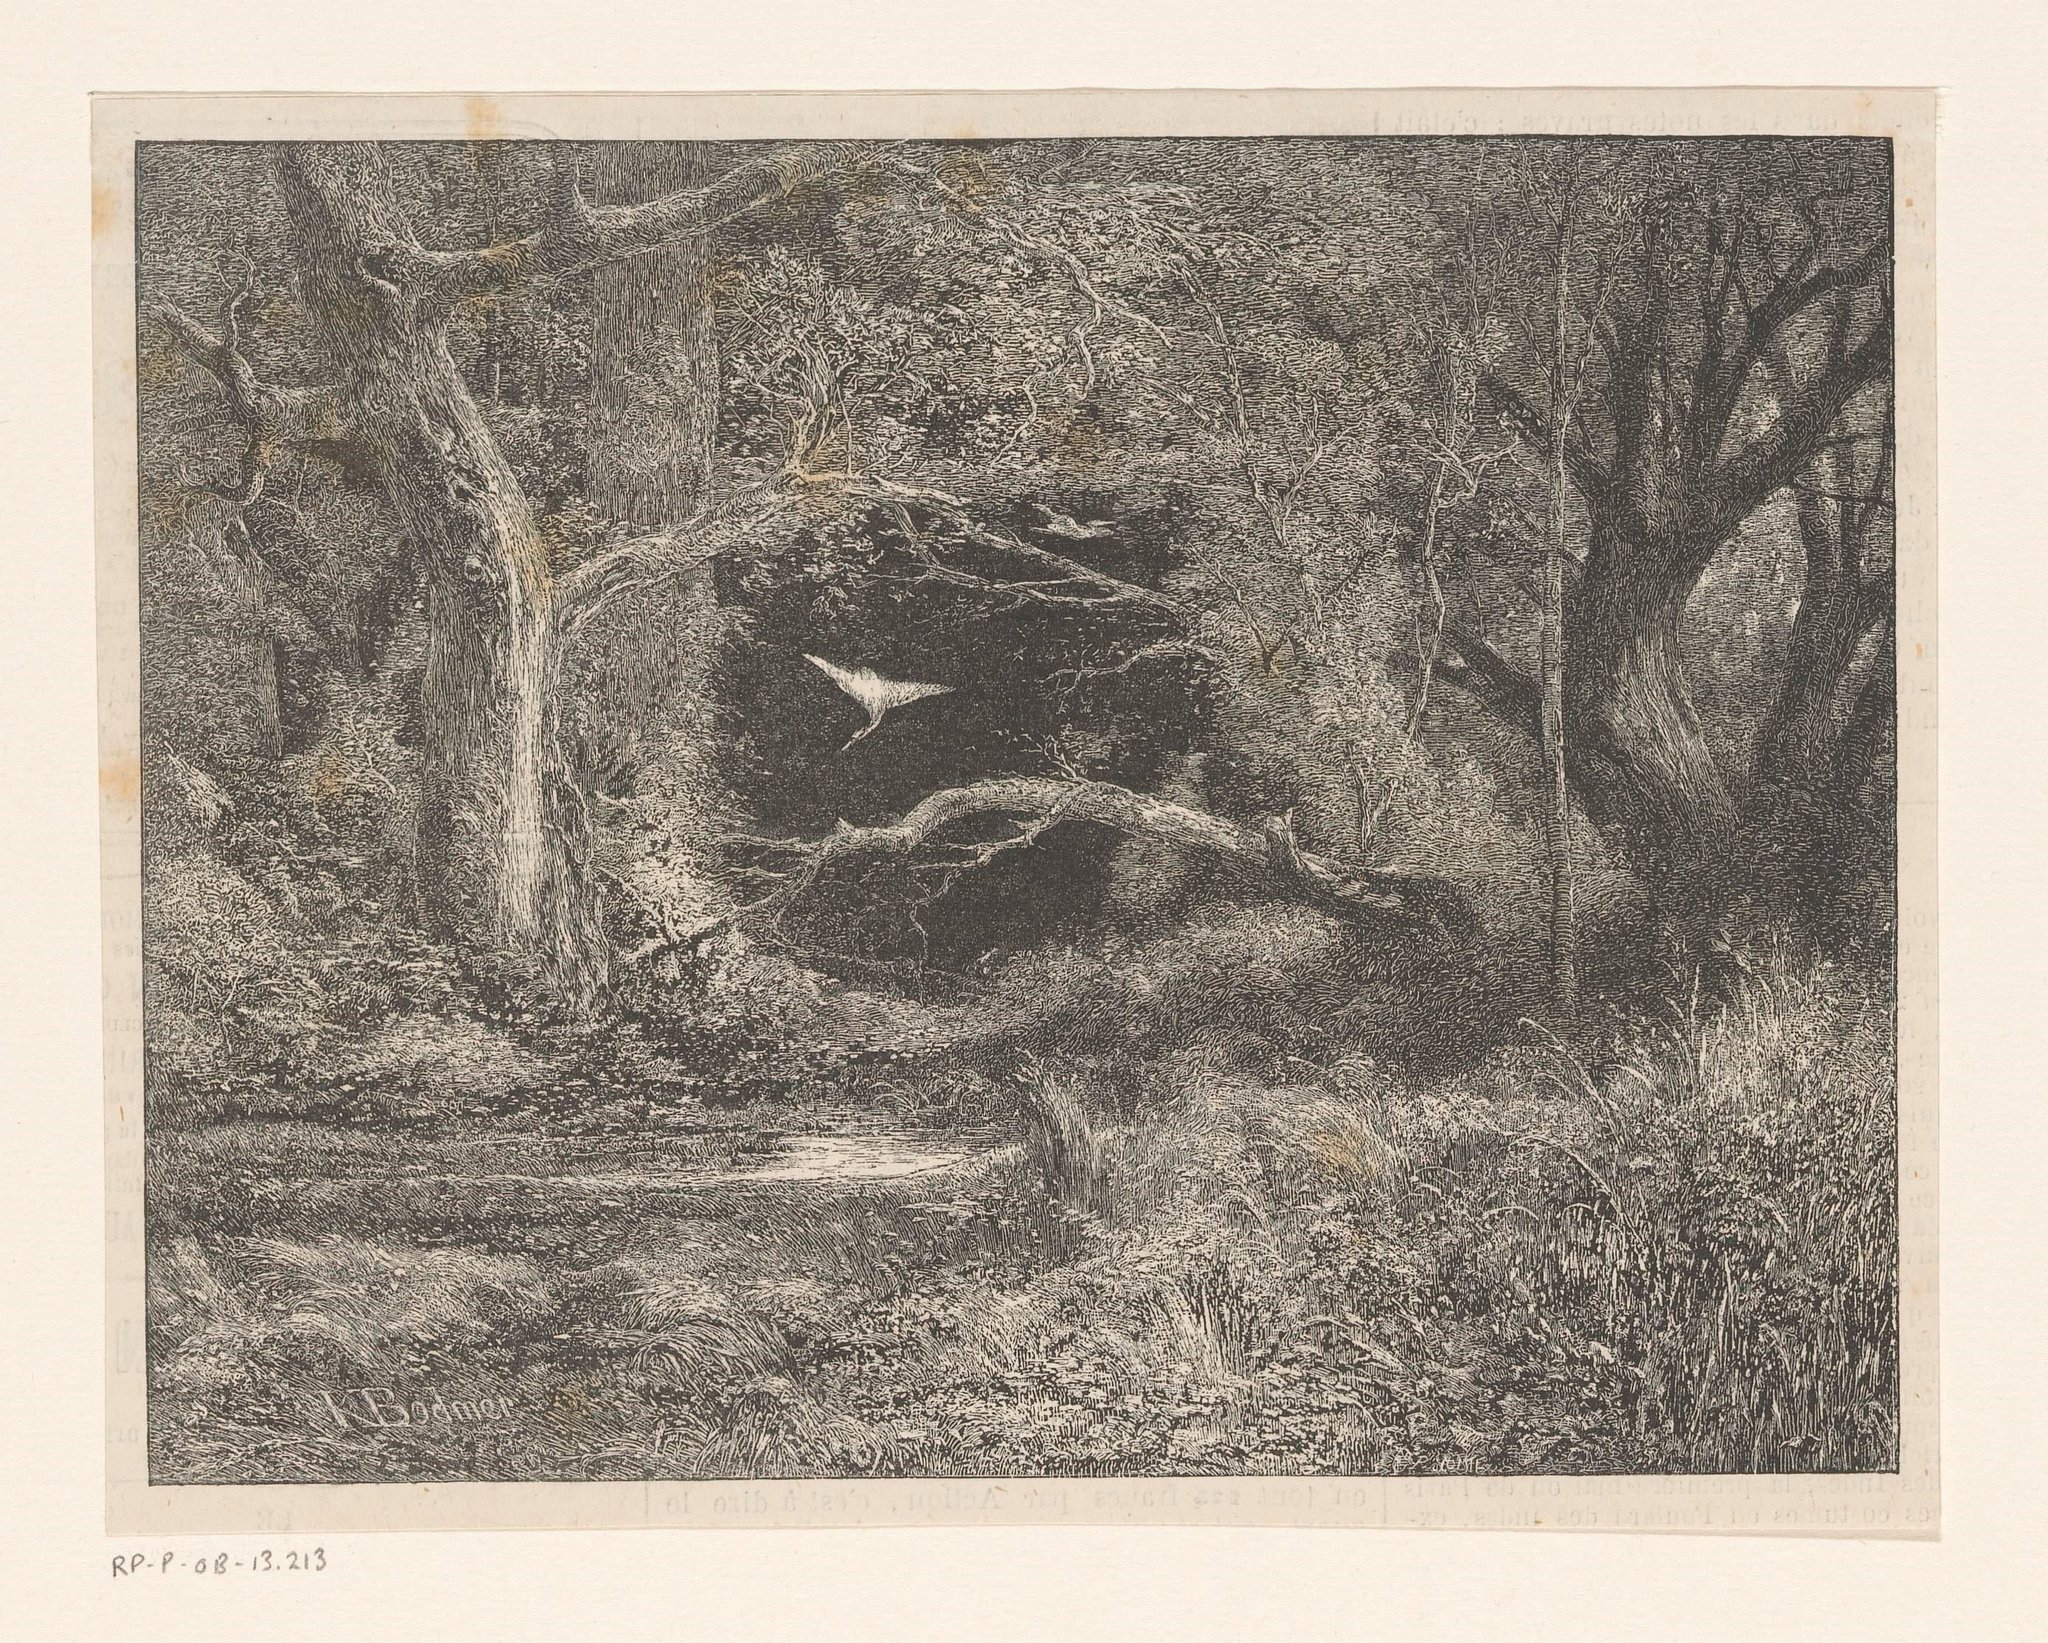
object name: illustration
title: Le héron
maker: karl bodmer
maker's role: draughtsman, painter, print maker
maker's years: 1809-1893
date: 1872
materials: paper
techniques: lithography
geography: barbizon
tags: shore-birds and wading-birds: heron, forest, wood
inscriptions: collector's mark: Lugt 2228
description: Prent afkomstig uit: L'illustration 59 (1872), p. 144. Deze prent is ook gebruikt in: Gauthier, Théophile. La nature chez elle. Parijs: A. Marc, 1870.